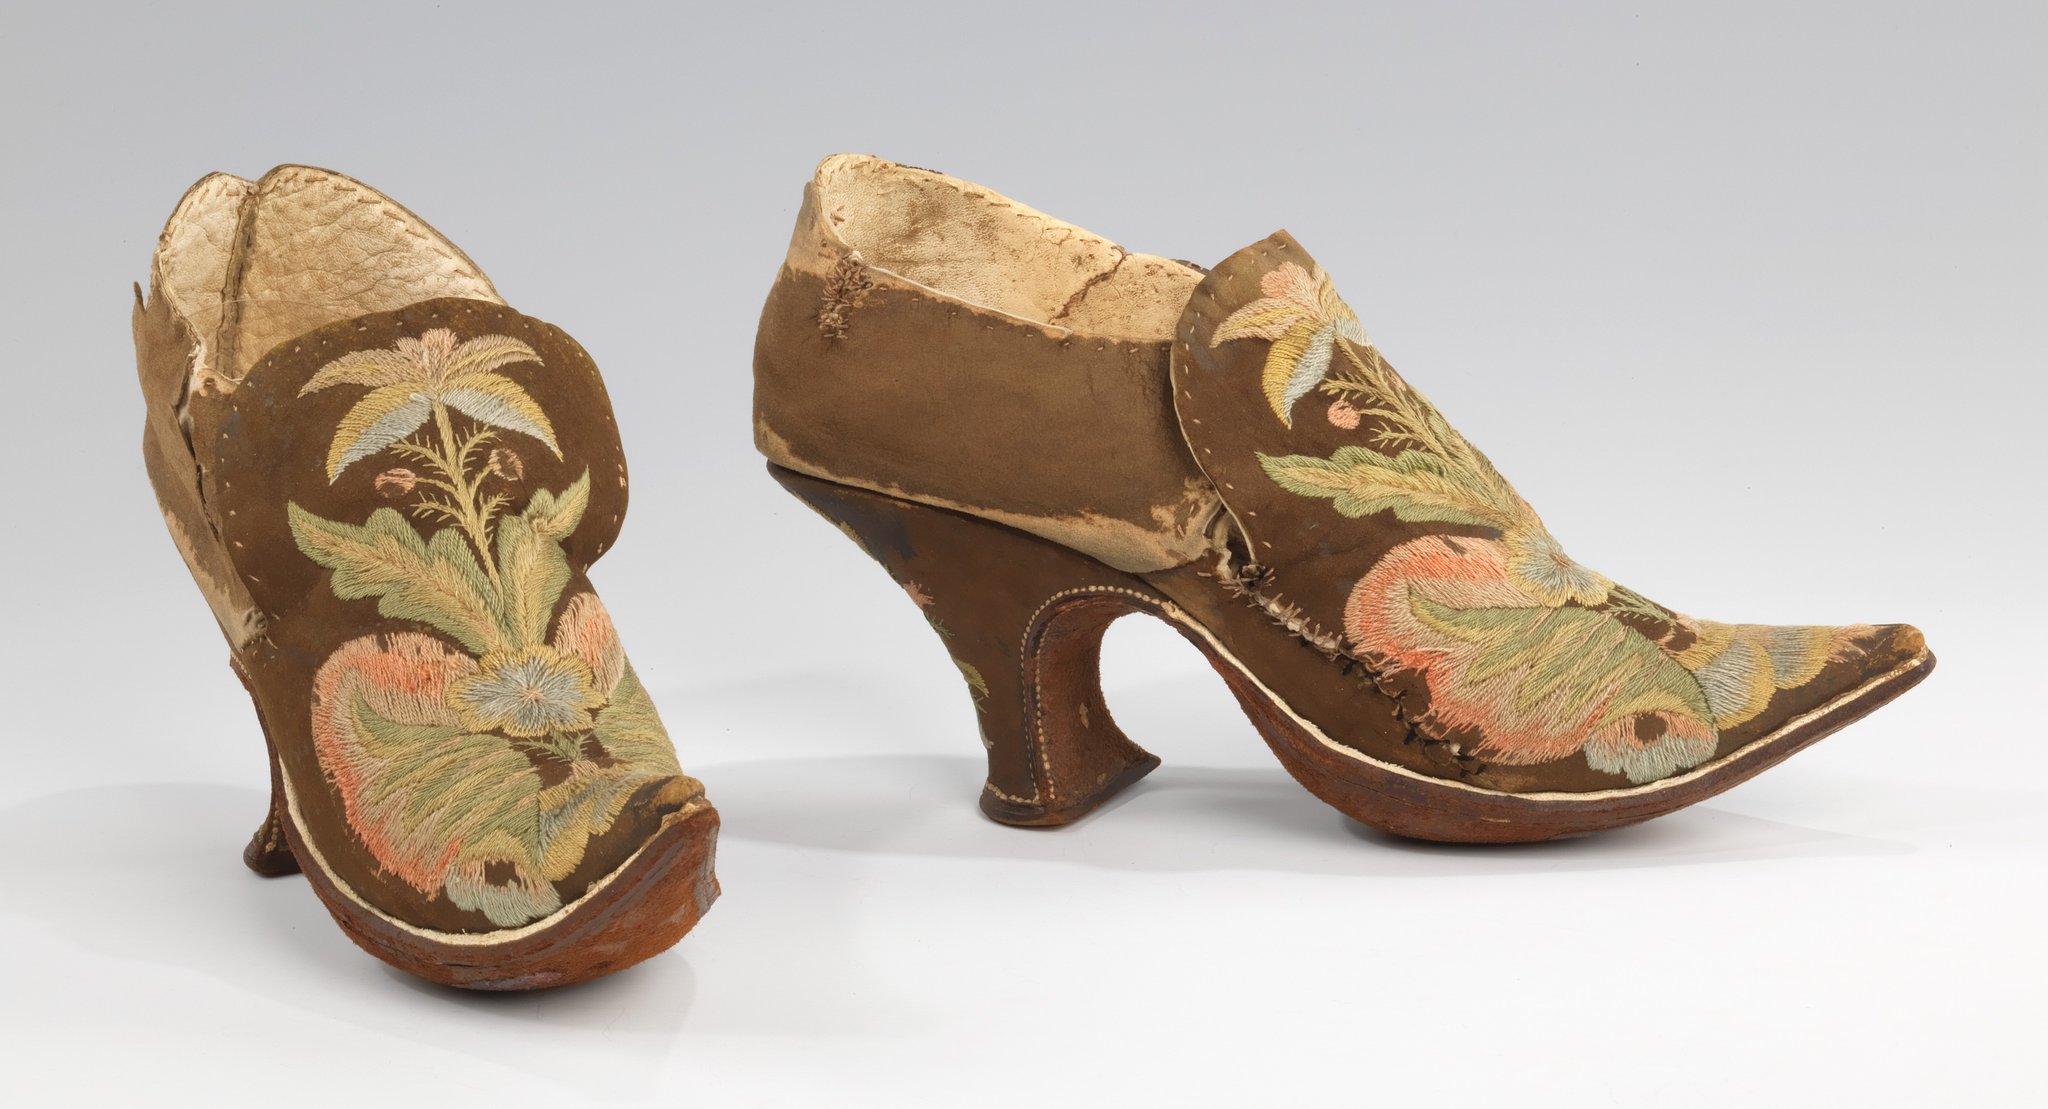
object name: shoe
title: Shoes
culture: european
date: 1690-1710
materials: leather, silk